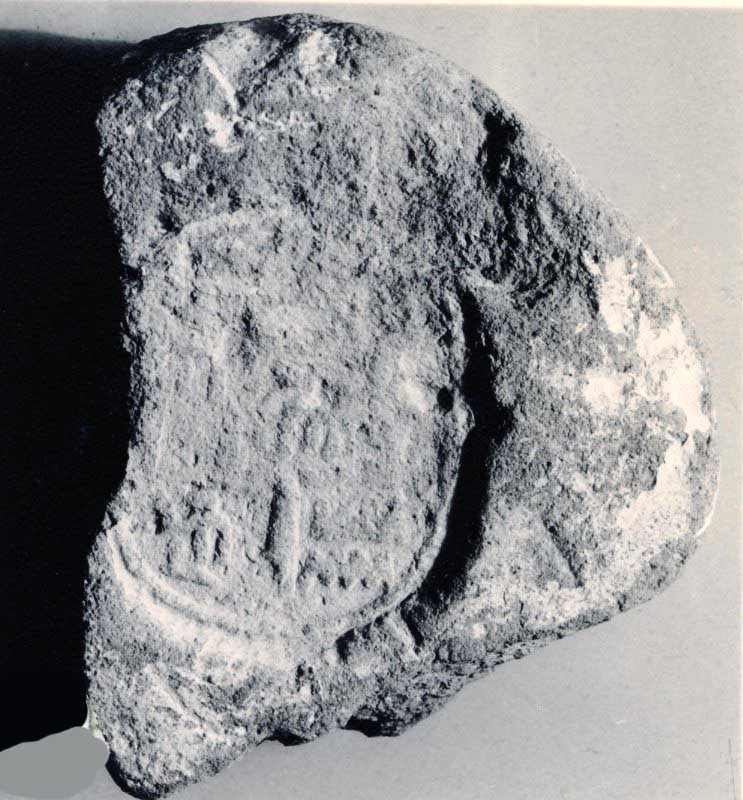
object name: cone, nebseny, oval impression, goldsmith of amun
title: Funerary Cone of the Goldsmith Nebseny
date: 1550-1295 BCE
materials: pottery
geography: egypt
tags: hieroglyphs